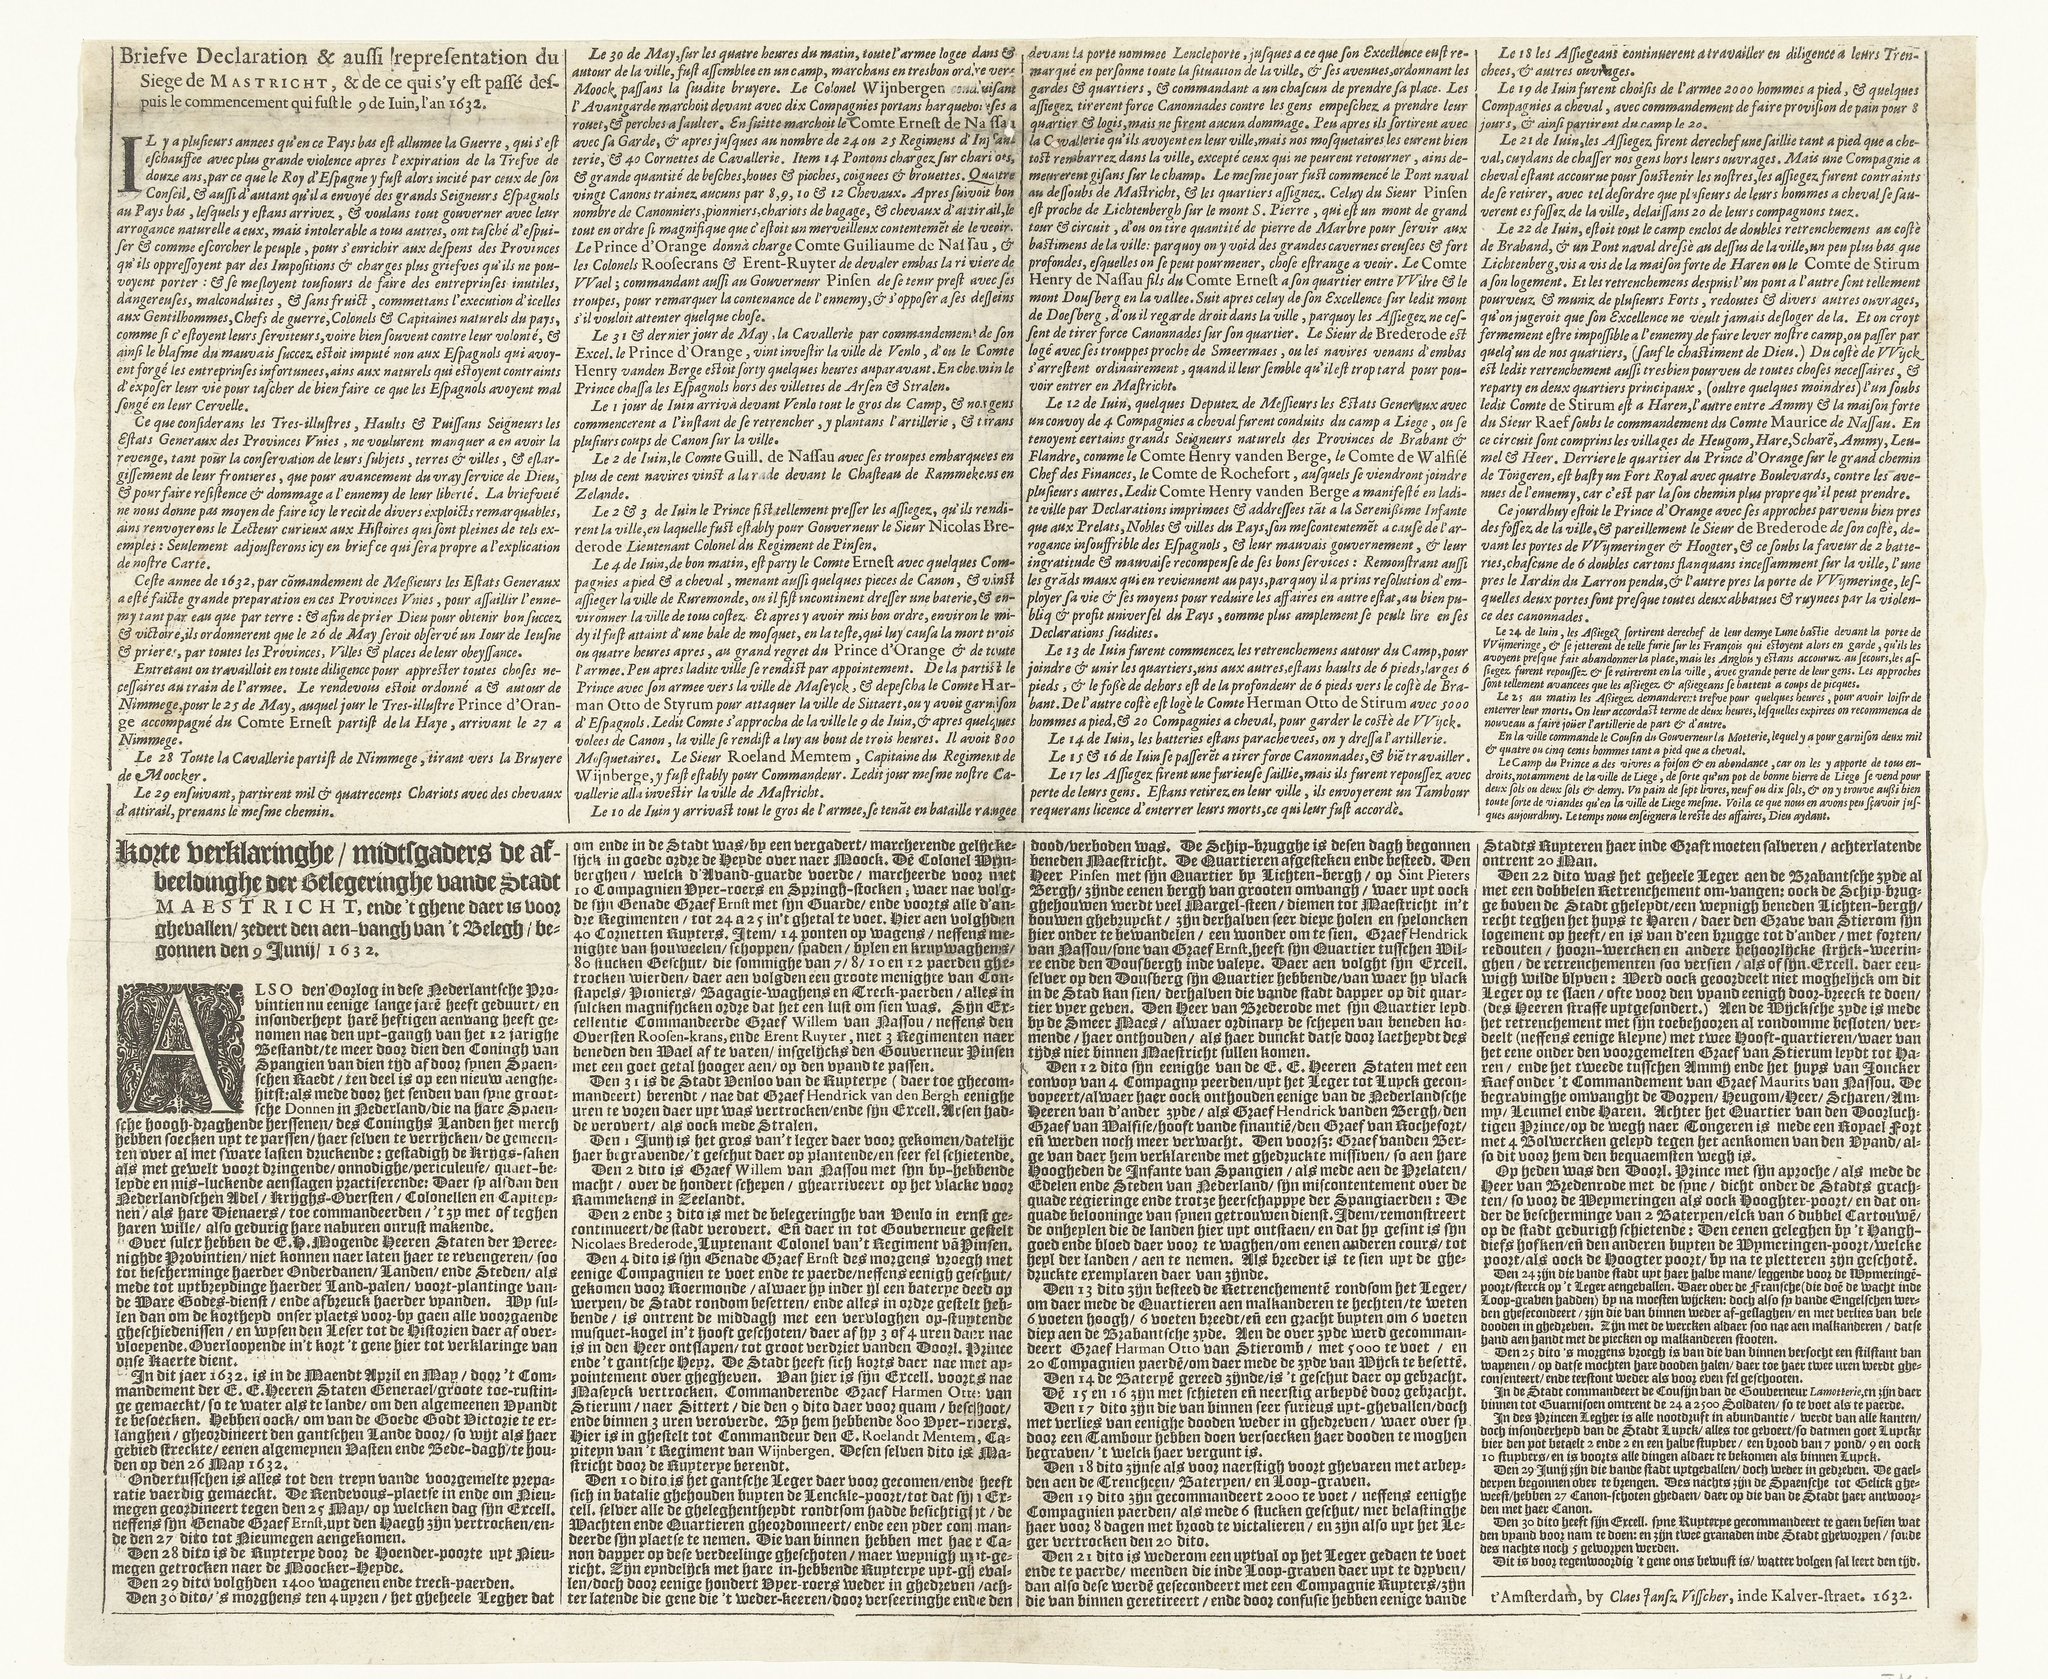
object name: print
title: Maestricht Beleegert, door Frederick Henderick bij der G.G. Prince van Orangien, Grave van Nassou (...) op den 9. dach van Junij int Jaer 1632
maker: claes jansz. visscher (ii)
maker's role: draughtsman, print maker, publisher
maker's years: 1586-1652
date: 1632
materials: paper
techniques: letterpress printing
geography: amsterdam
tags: delft, frederick henry (prince of orange), maastricht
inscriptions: date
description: Tekstblad behorend bij de kaart van het beleg van Maastricht door het Staatse leger onder stadhouder Frederik Hendrik, 9 juni tot 21 augustus 1632. Tekst in Frans in Nederlands in 4 kolommen boven elkaar.